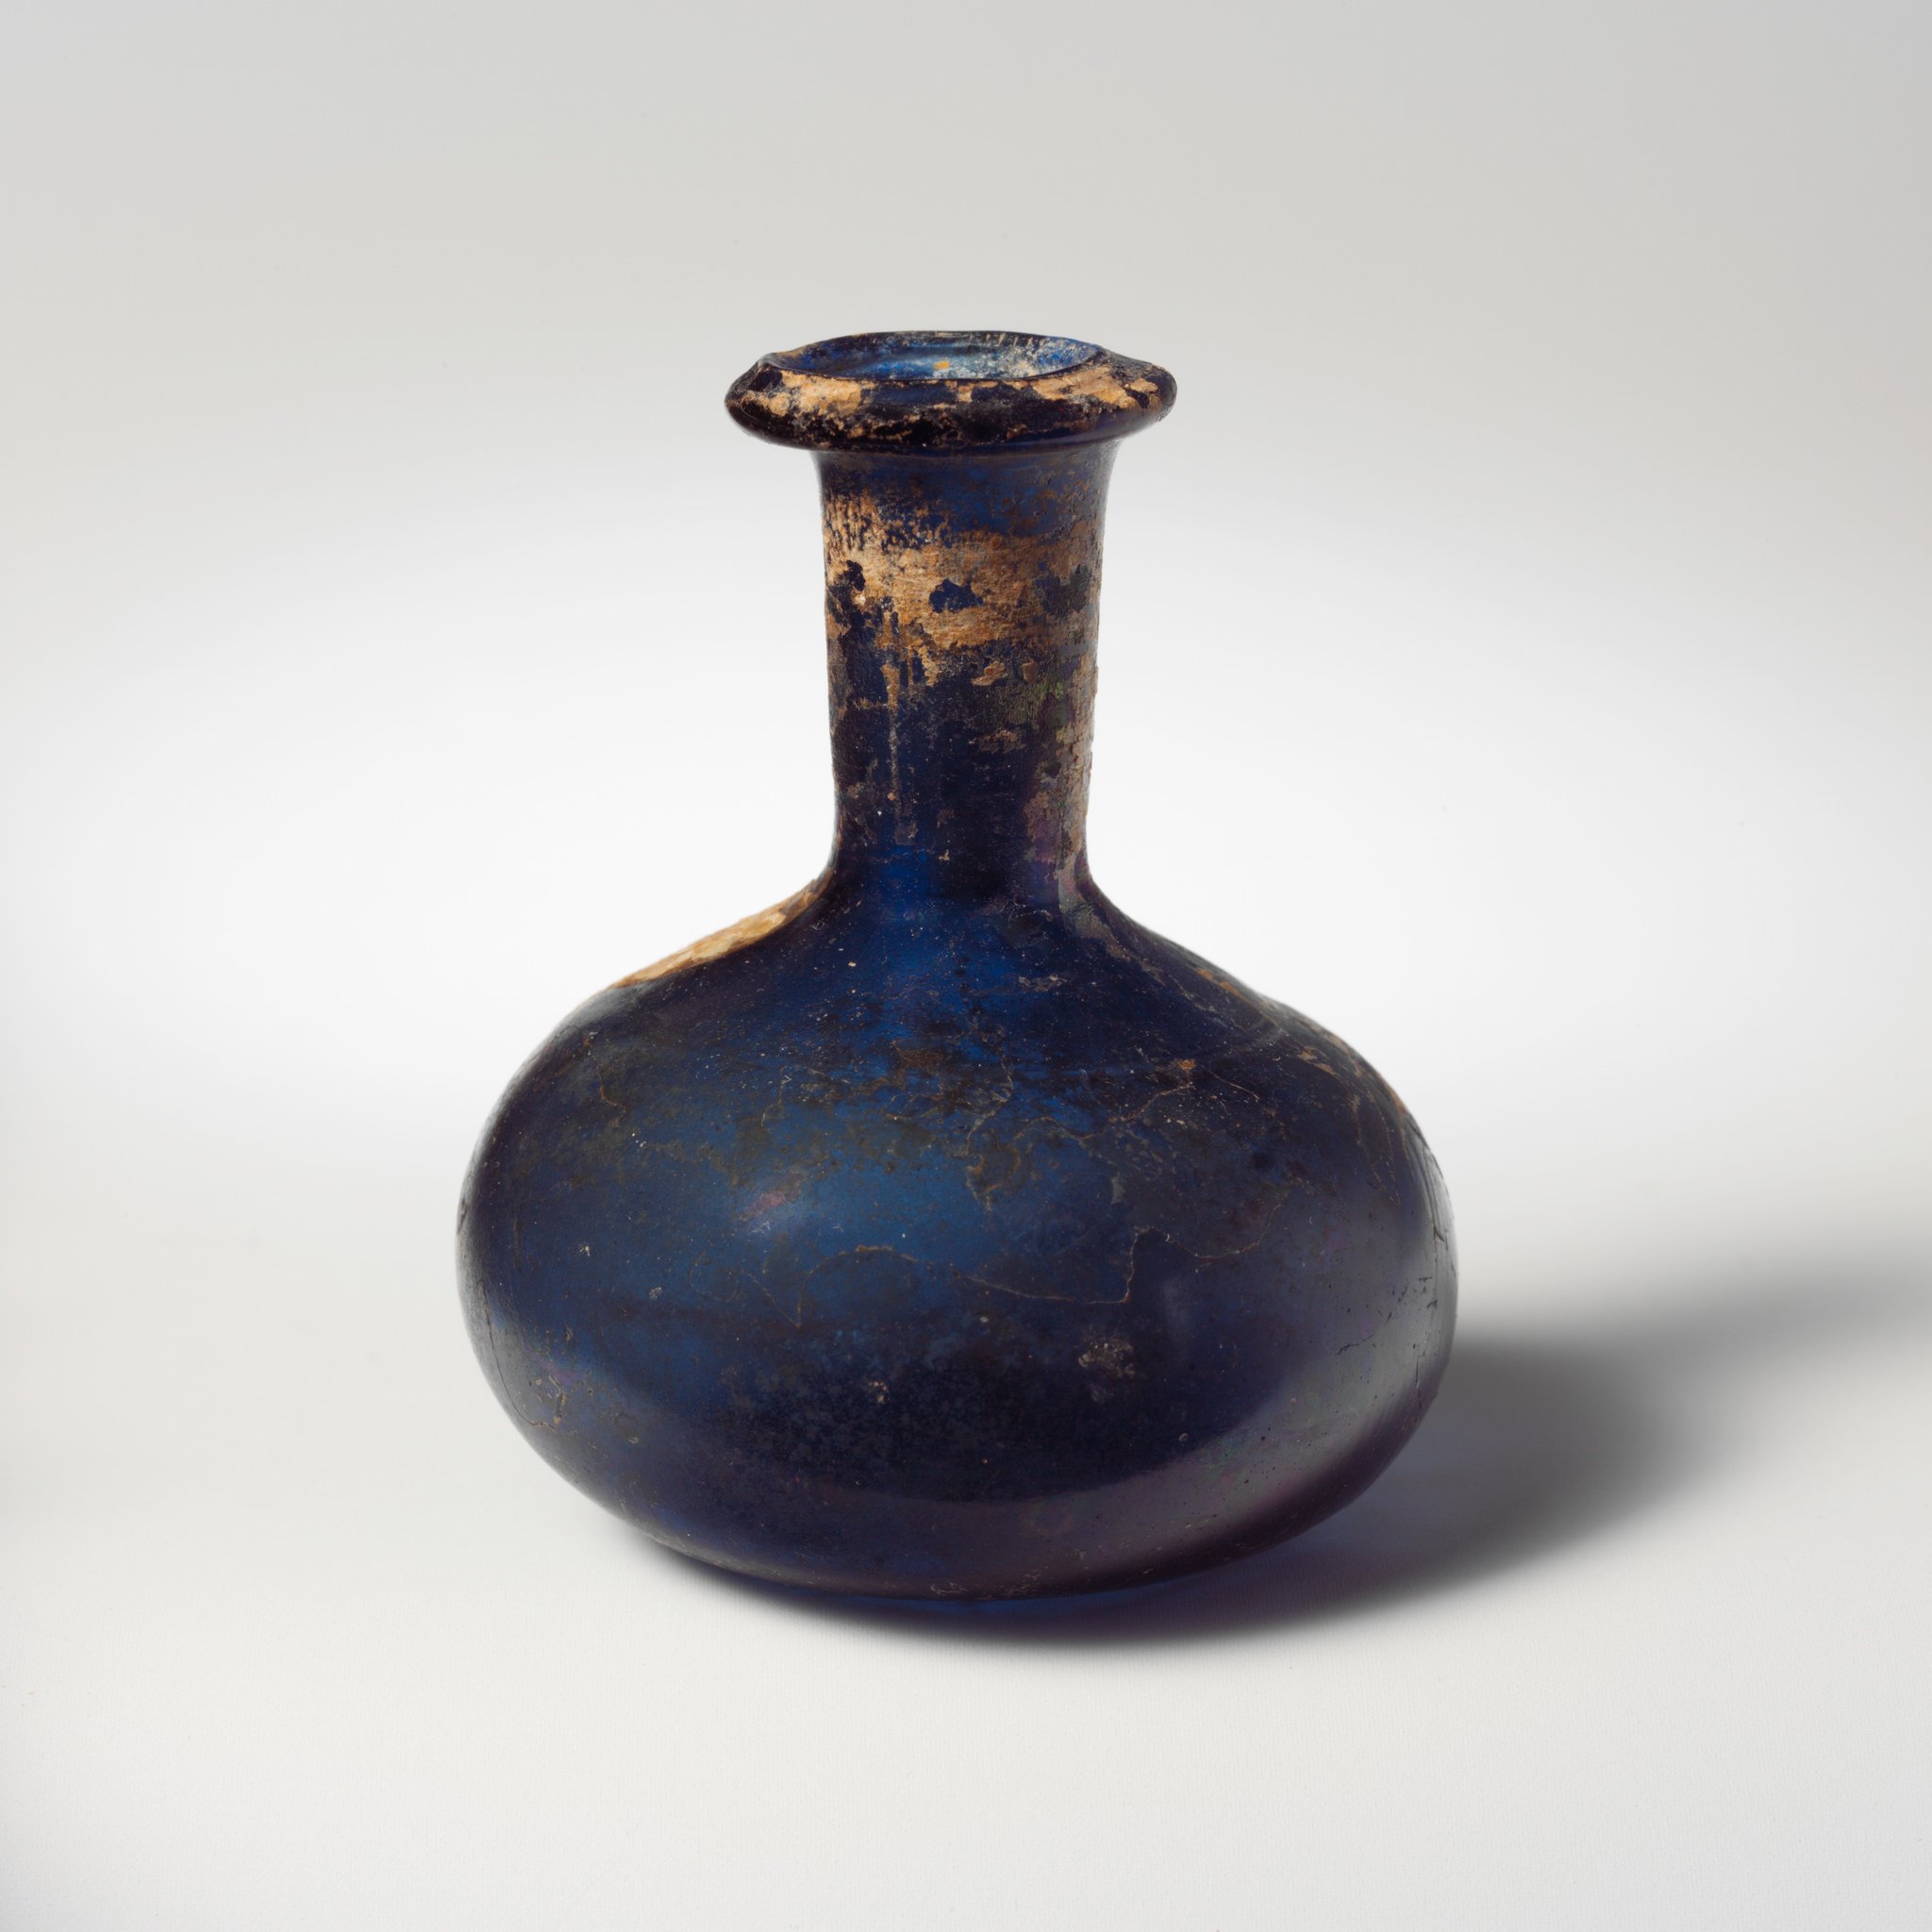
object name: perfume bottle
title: Glass perfume bottle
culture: roman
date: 1-100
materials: glass